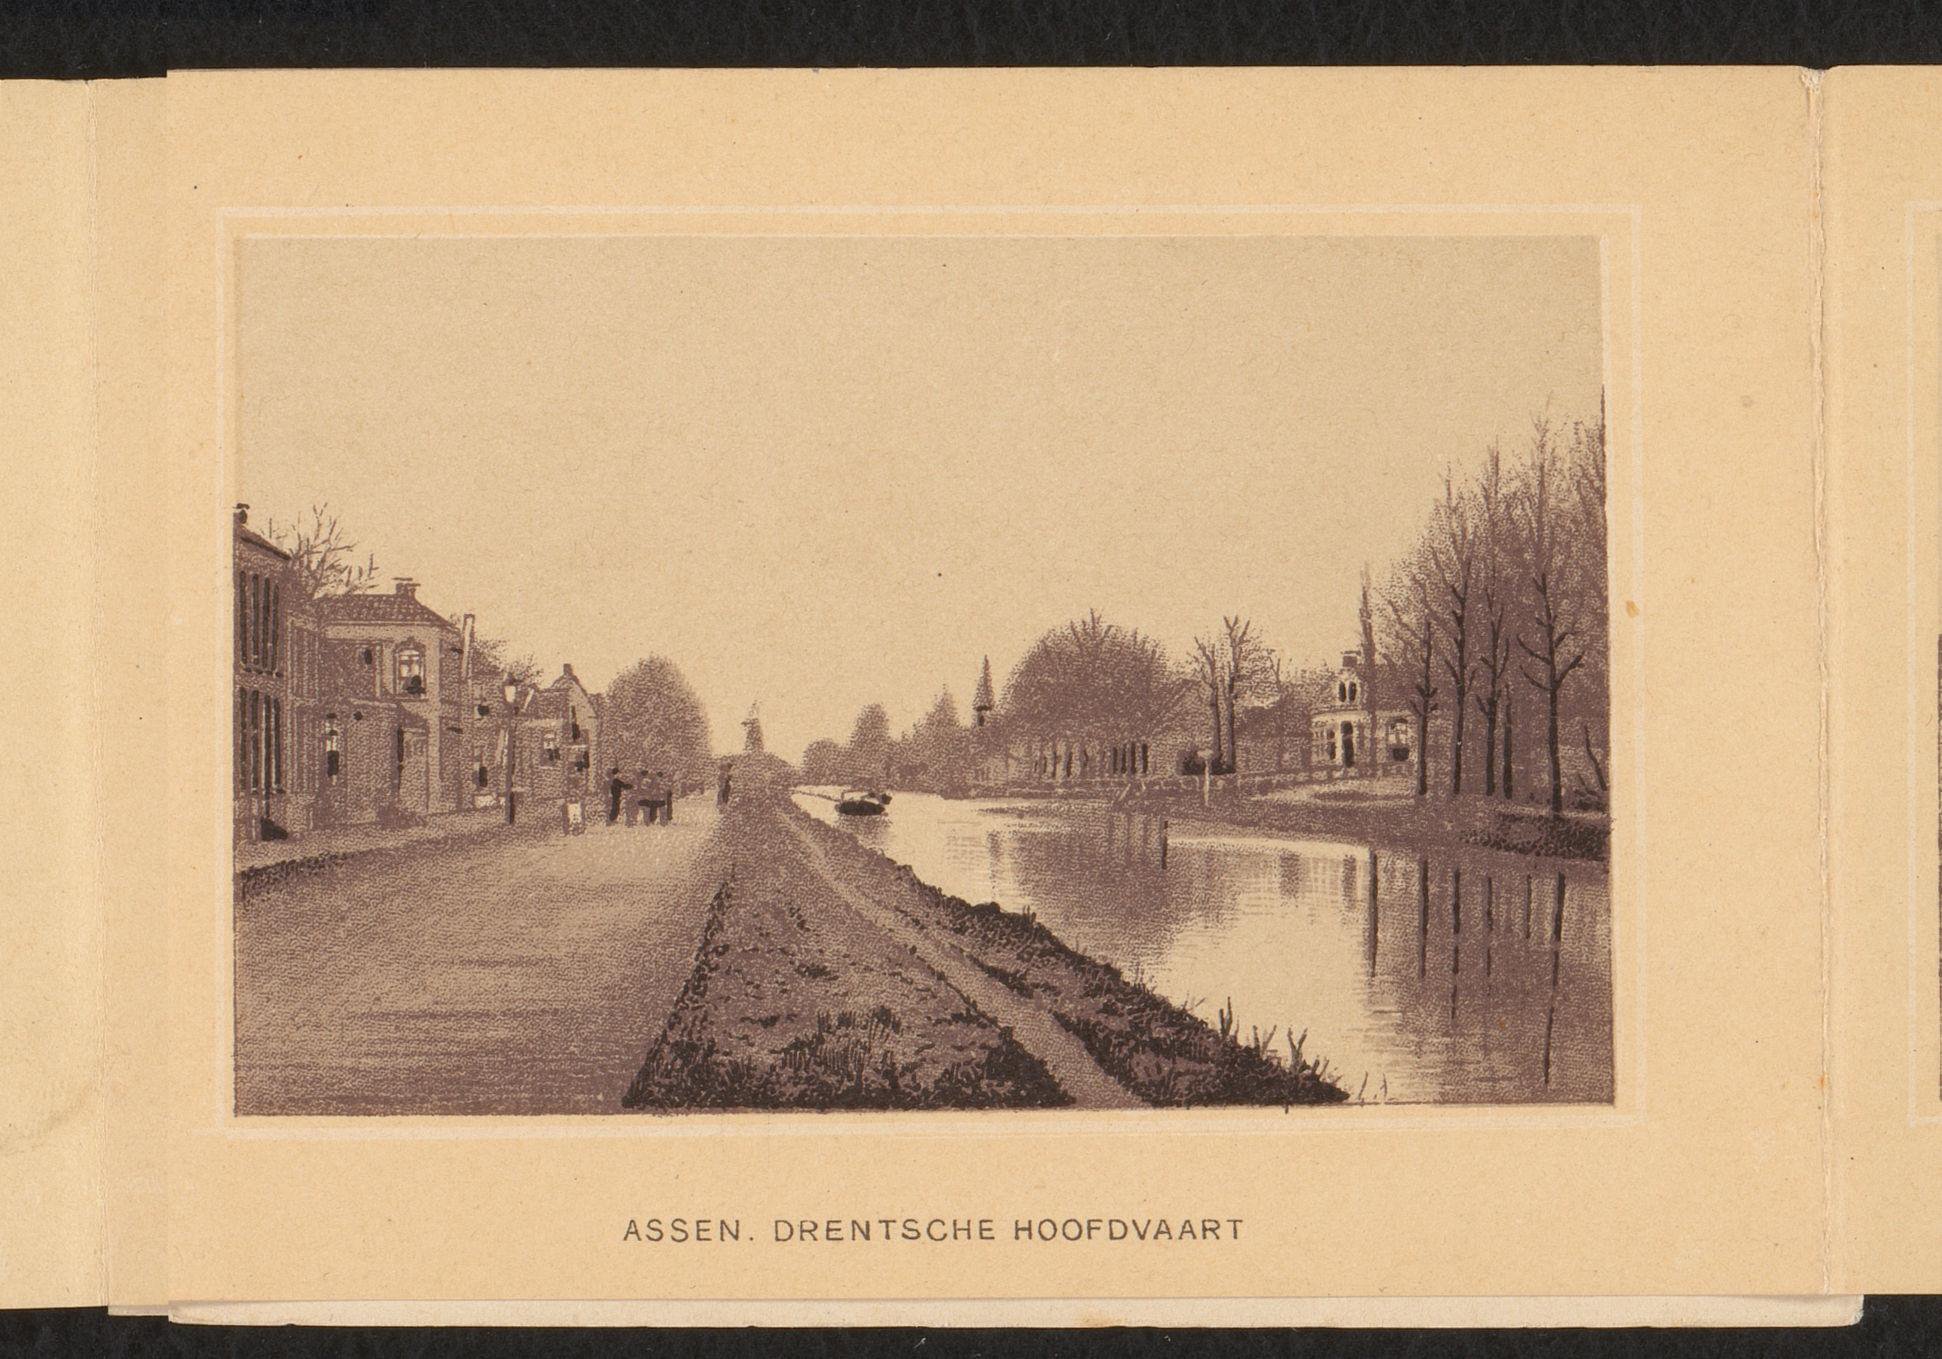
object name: ansichtkaart, prentbriefkaart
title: Assen. Drentsche hoofdvaart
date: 1887-1891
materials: paper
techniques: lithograph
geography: amsterdam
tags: city-view, and landscape with man-made constructions, small canal, ditch